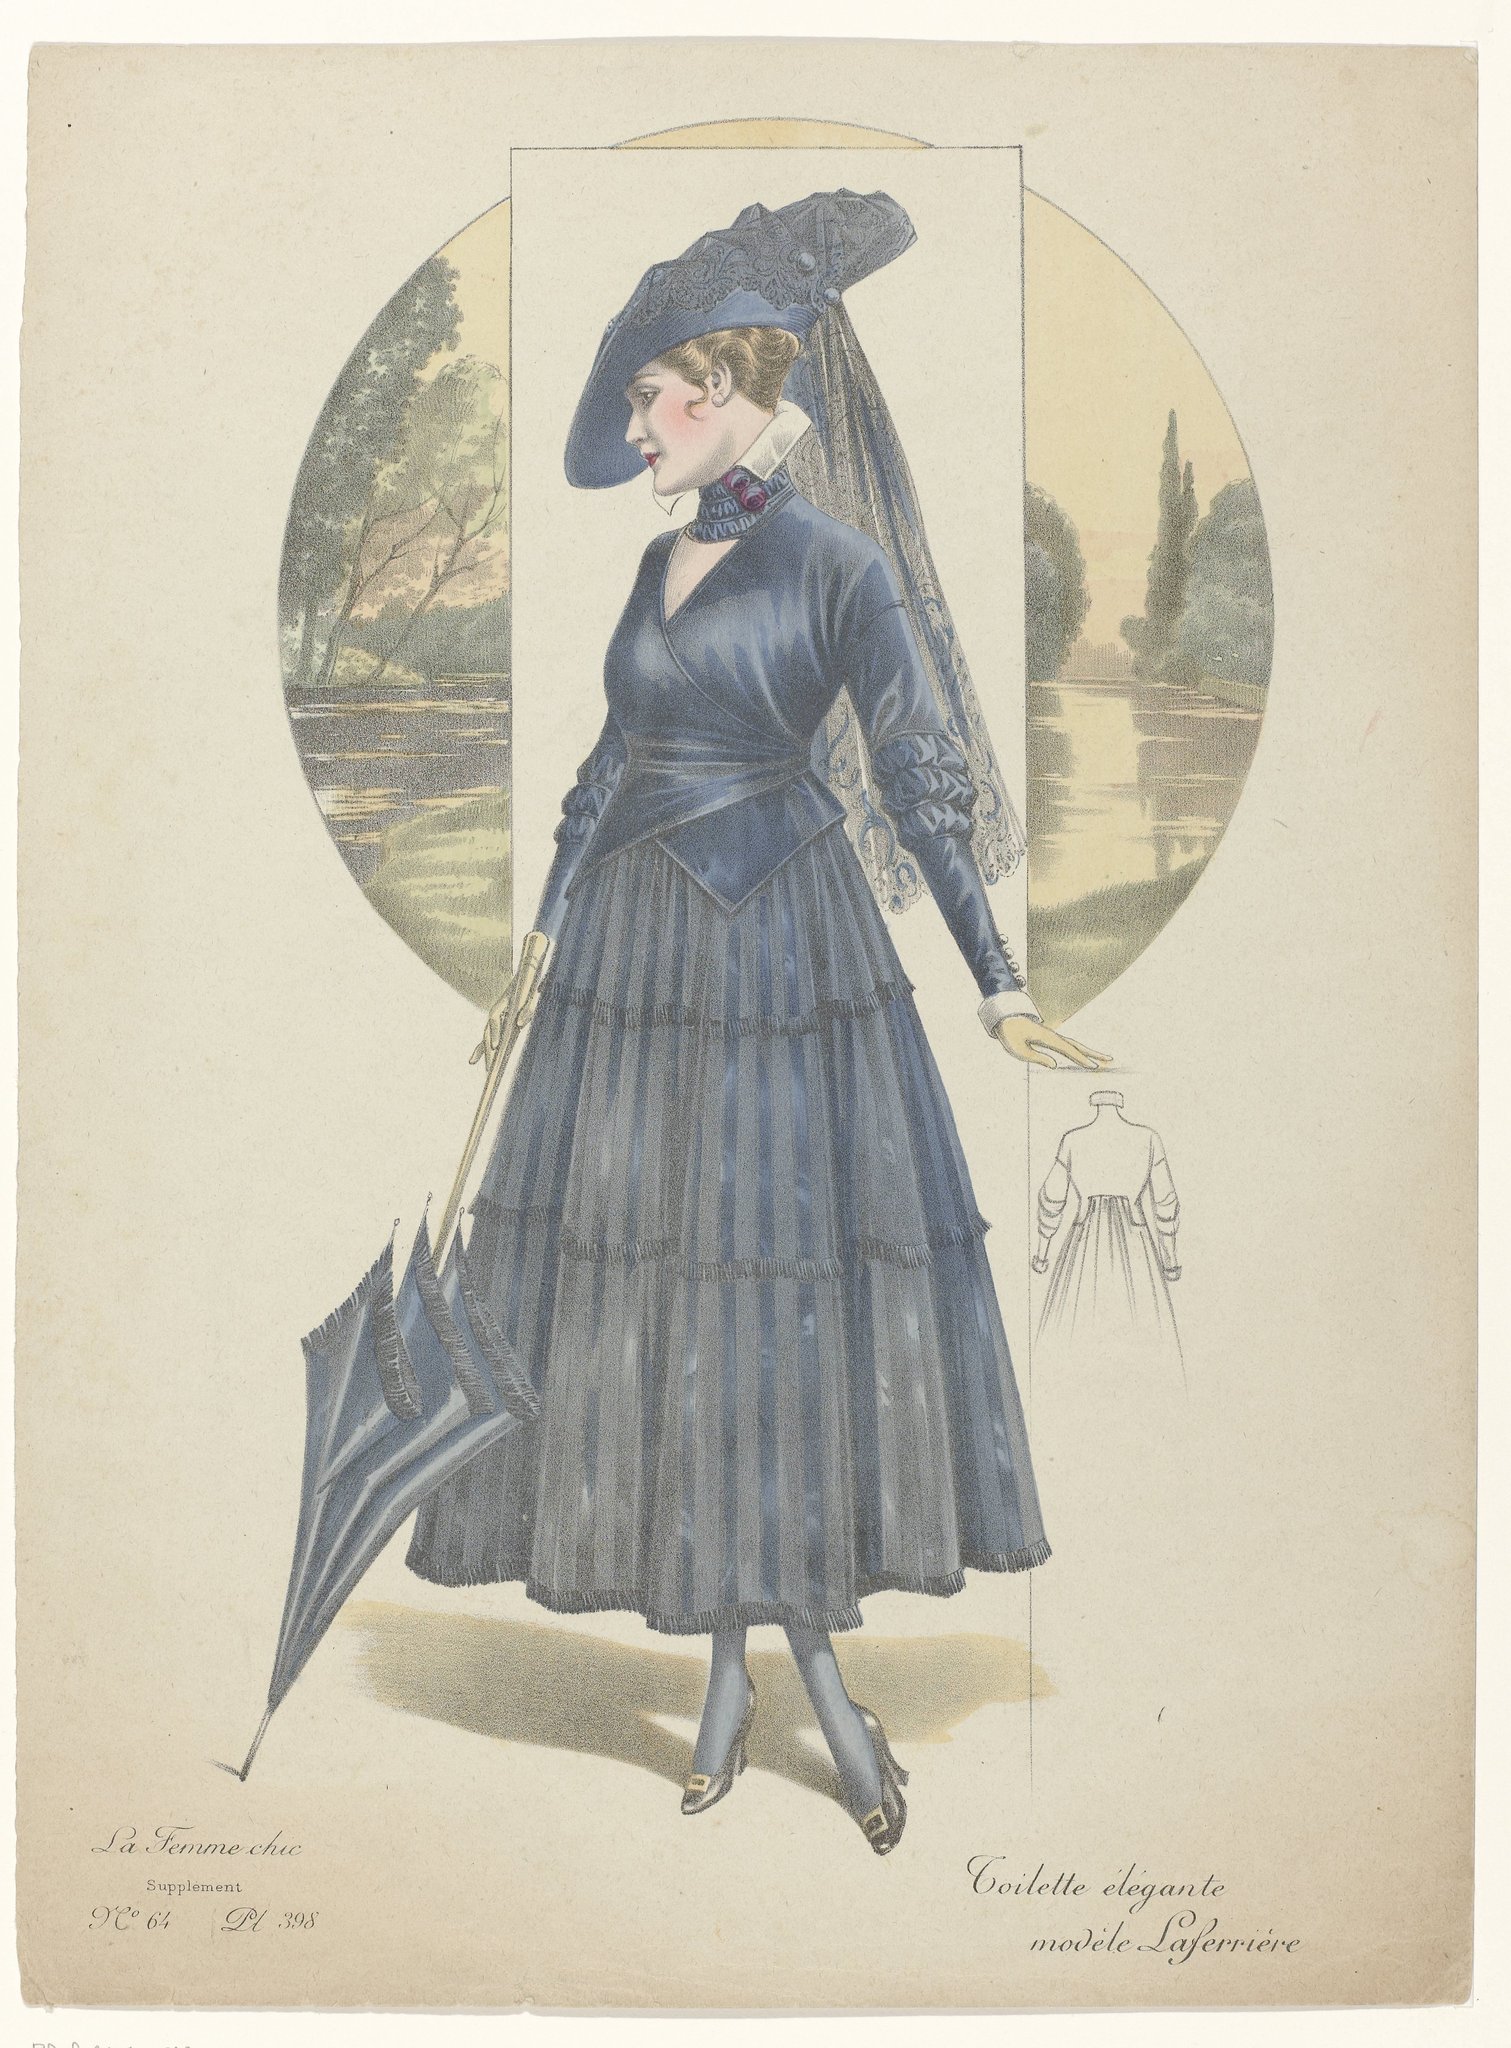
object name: fashion print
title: Gown by Maison Laferrière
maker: Anonymous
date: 1911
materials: paper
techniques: hand coloring, lithograph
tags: clothing for the upper part of the body (+ women's clothes), veil (+ women's clothes), neck-gear: collar (+ women's clothes), fashion plates, head-gear: hat (+ women's clothes), skirt (+ women's clothes), parasol, sunshade (+ women's clothes)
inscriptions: caption: ‘Toilette élégante modèle Laferrière’, title: ‘La Femme chic / Supplement / No. 64 Pl 398’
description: In 1869 the fashion designer Madeleine Laferrière opened what was to become a highly esteemed maison on rue Taitbout in Paris. By the end of the century, it had developed into an eminent fashion house on a par with the likes of Doucet and Paquin. Maison Laferrière’s international clientèle included aristocrats and royalty. Among her regular customers were Queen Maud of Norway and Alexandra of Denmark.